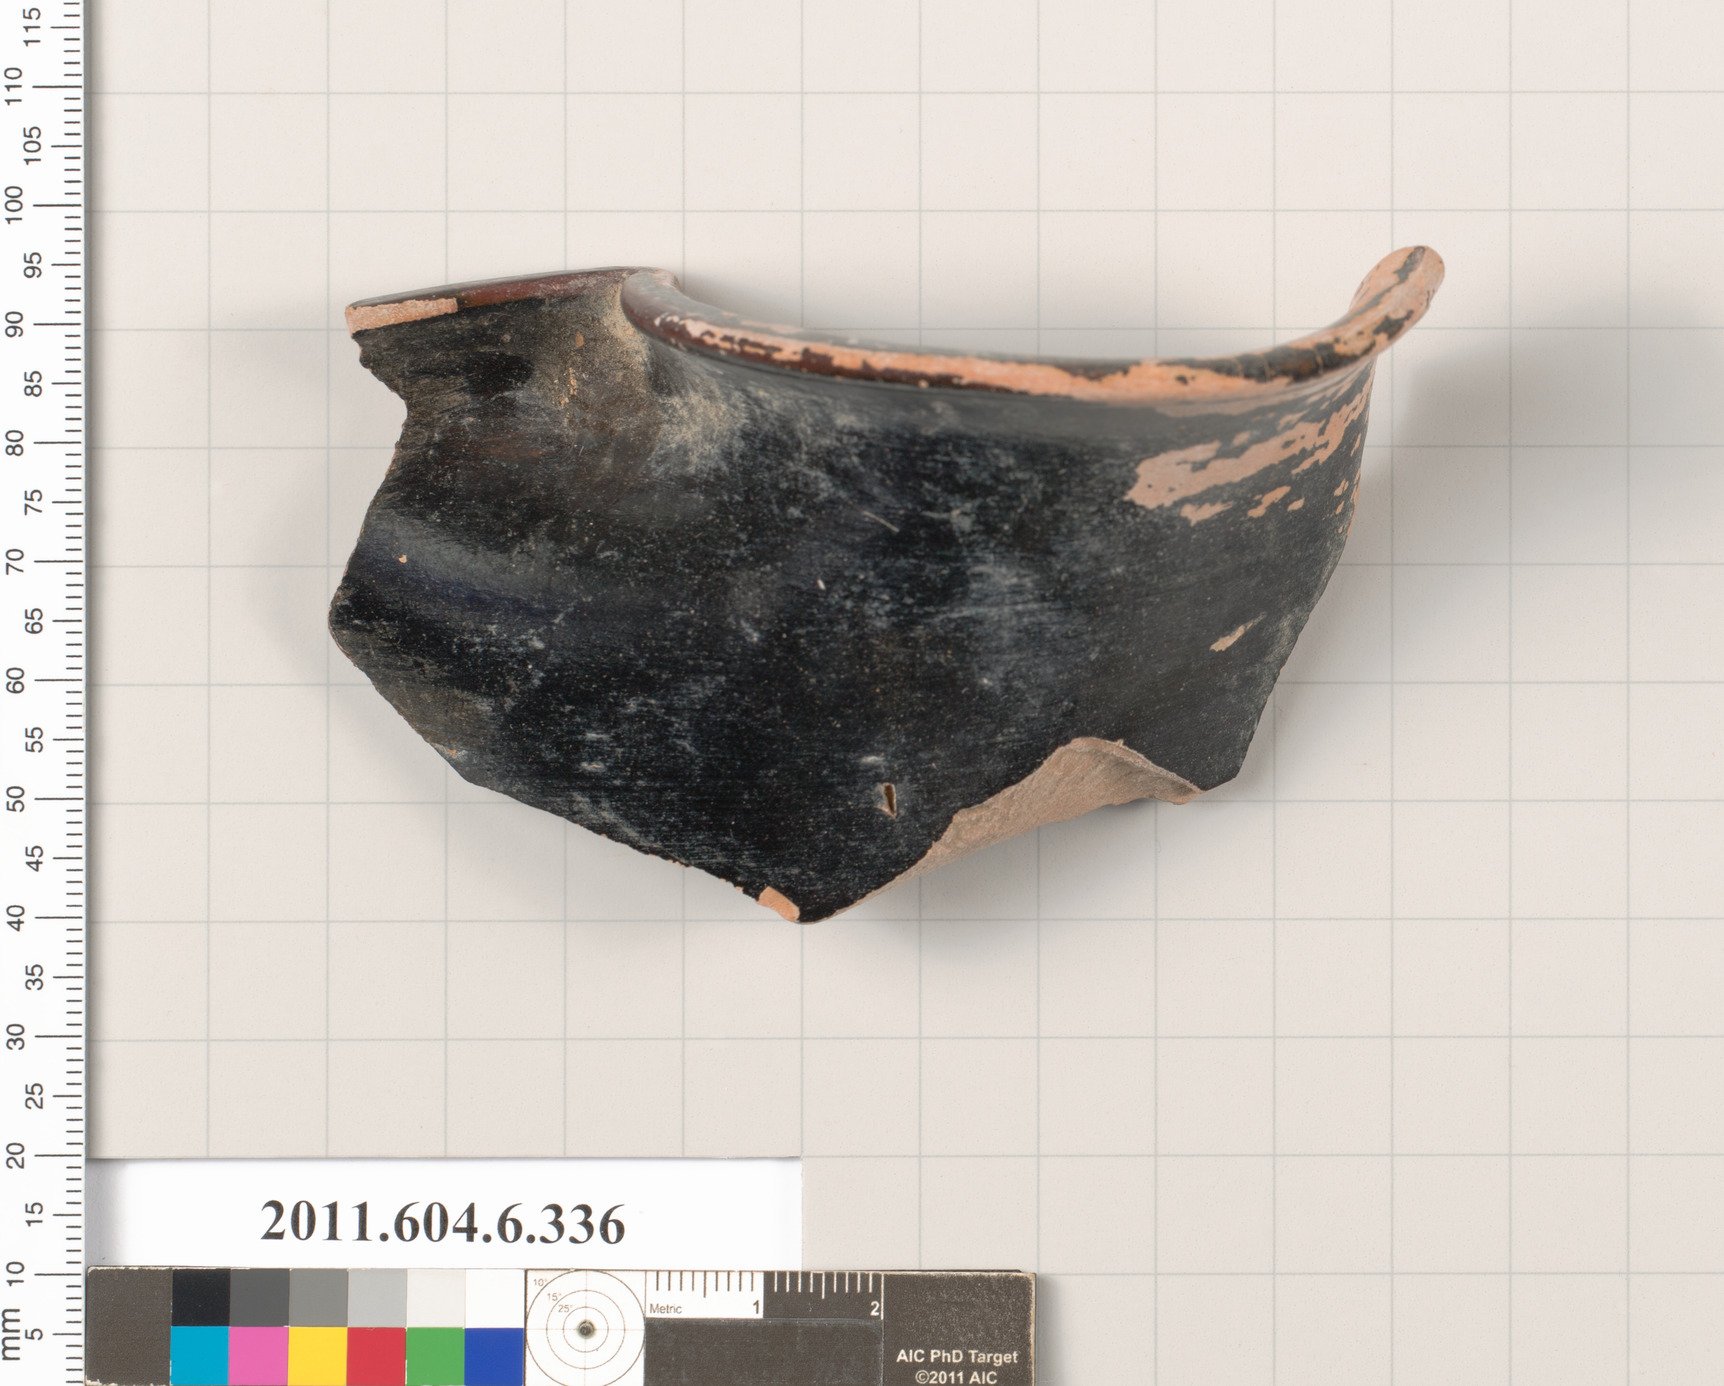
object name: chou fragment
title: Terracotta fragment of an oinochoe: chous (jug)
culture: greek, attic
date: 450-401 BCE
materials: terracotta